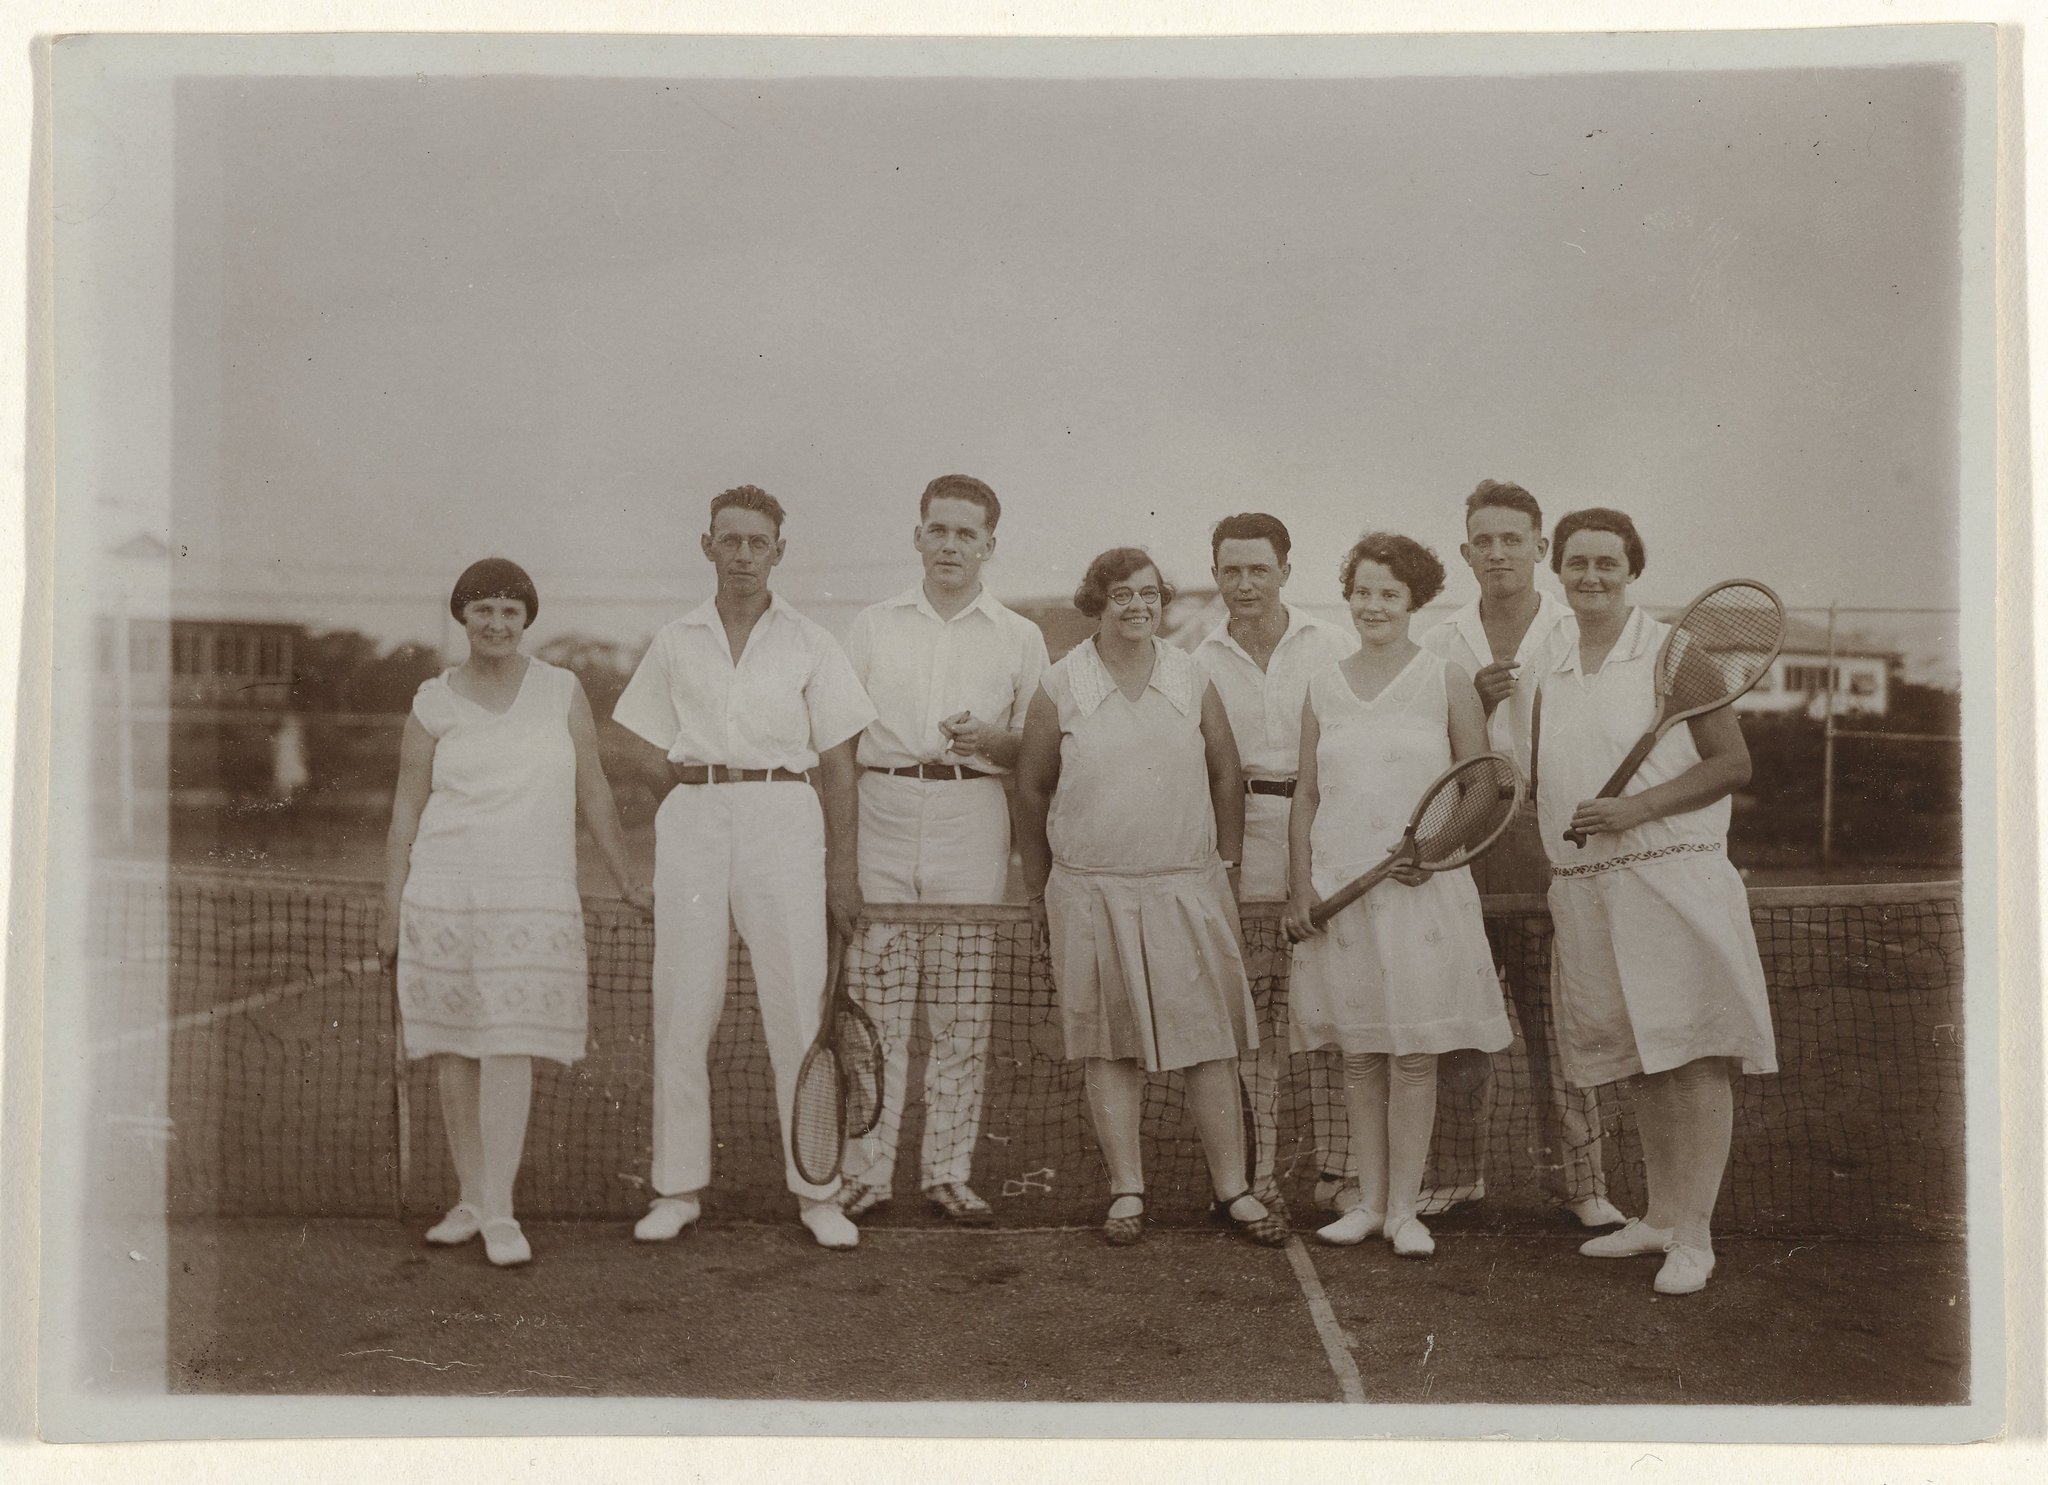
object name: photograph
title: Groepsportret op de tennisbaan van Moengo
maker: Anonymous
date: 1929-1930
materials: photographic support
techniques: photography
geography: suriname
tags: tennis, lawn-tennis